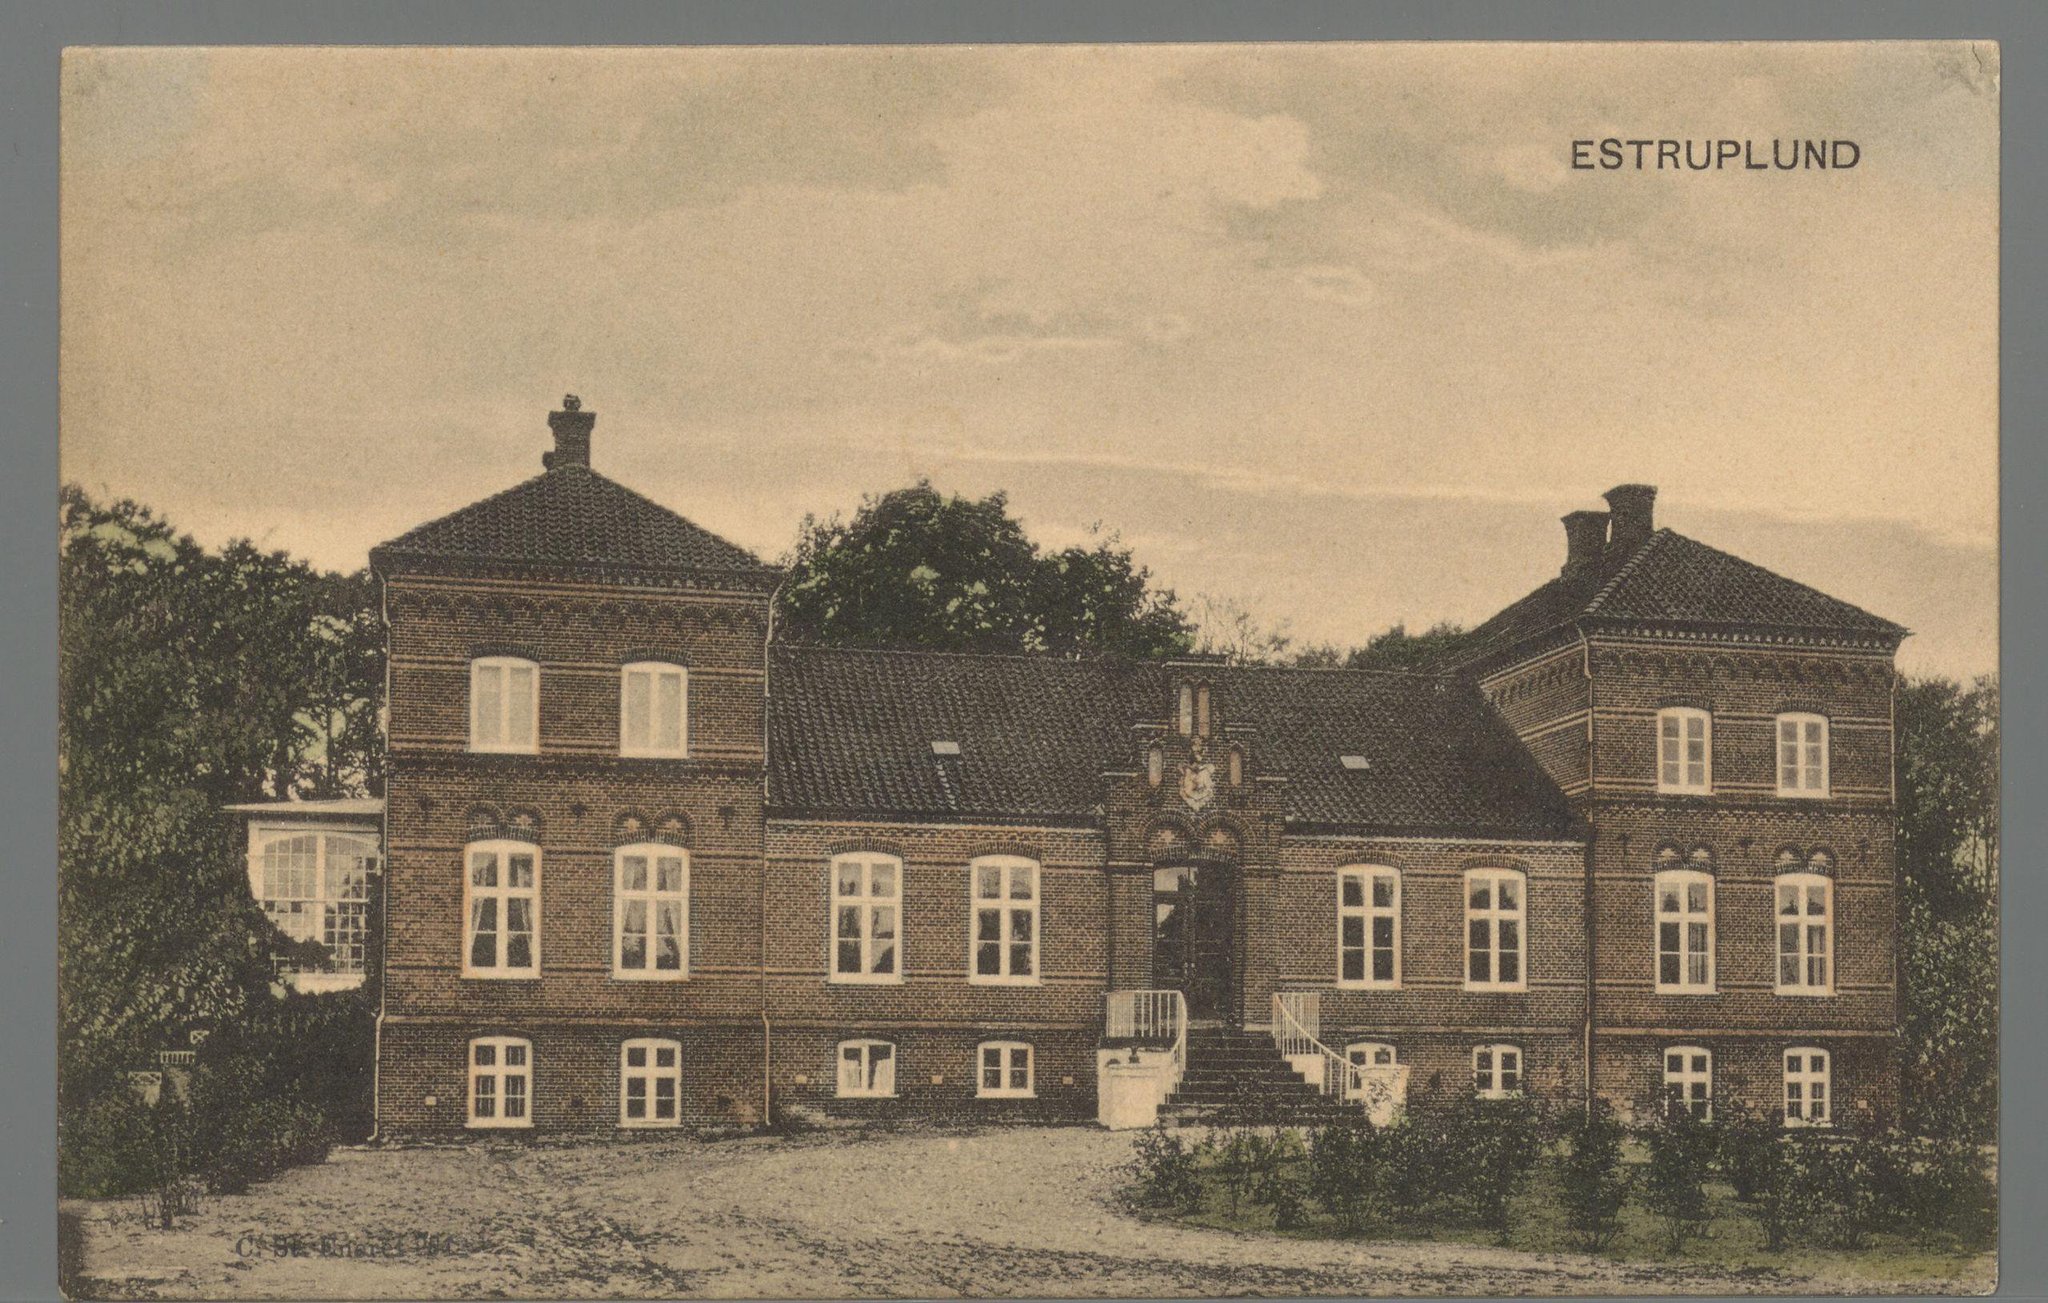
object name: ansichtkaart, prentbriefkaart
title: Estruplund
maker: Anonymous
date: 1906-1920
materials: cardboard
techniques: photograph, lithograph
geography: copenhagen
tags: garden, rural housing, e.g. country-house, villa, cottage